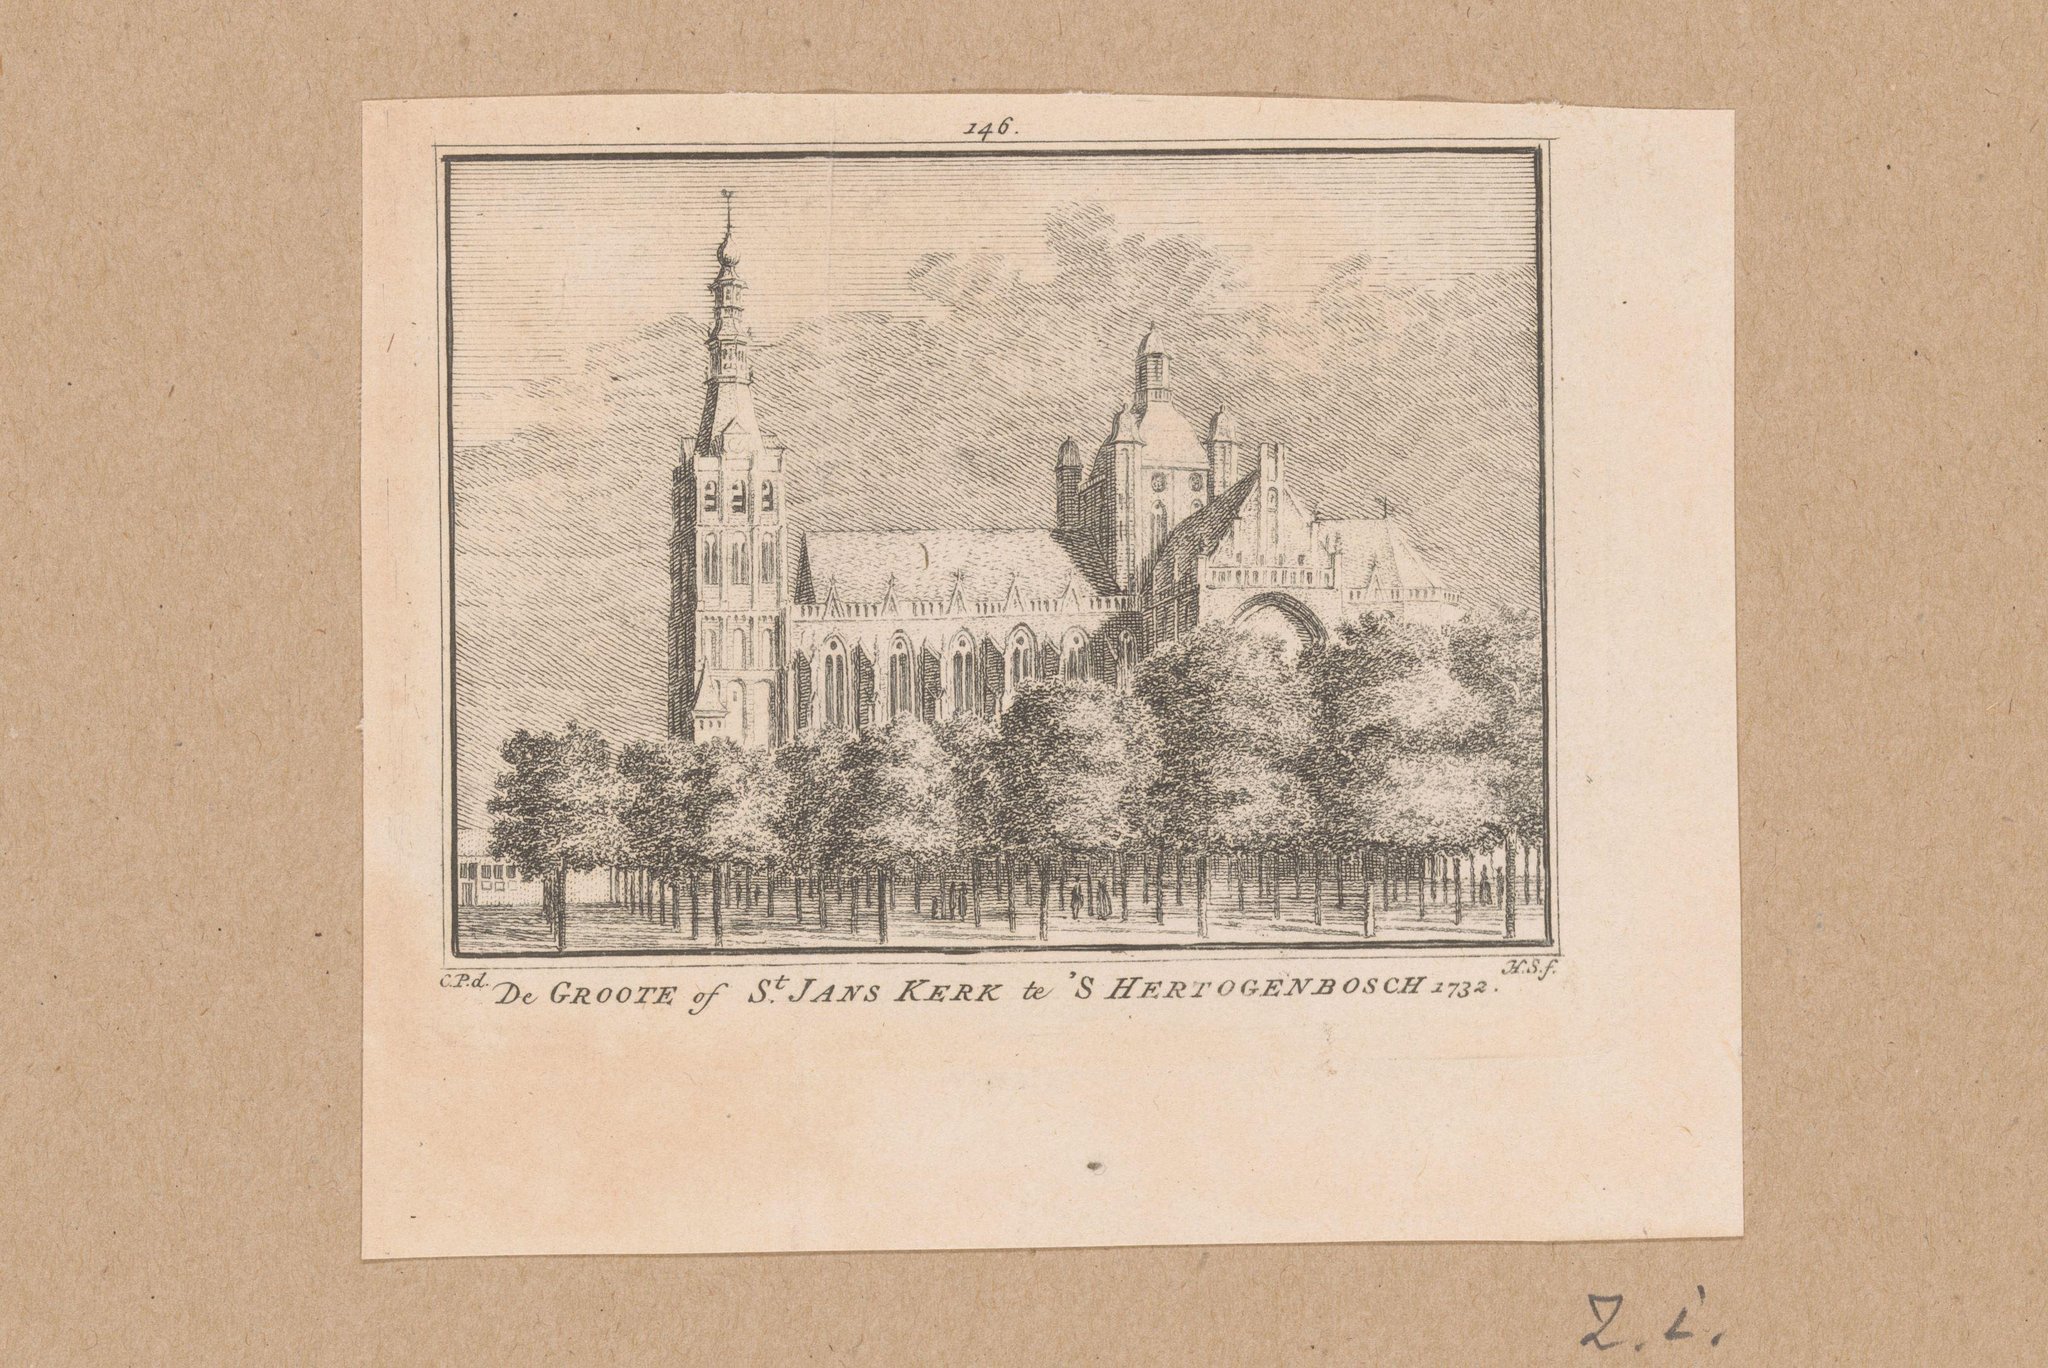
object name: print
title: De Groote of St. Jans kerk te 's Hertogenbosch 1732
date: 1746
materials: paper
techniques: engraving, etching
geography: amsterdam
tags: church (exterior)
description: Prent uit: Spilman, Hendrik. Het verheerlykt Nederland, of kabinet van hedendaagsche gezigten. 9 dln. Amsterdam: Isaac Tirion, 1745-1774, dl. 2 (1746).